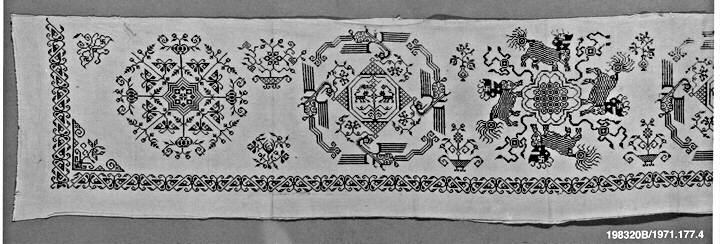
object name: valance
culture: chinese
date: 1801-1900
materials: cotton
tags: lions,flowers